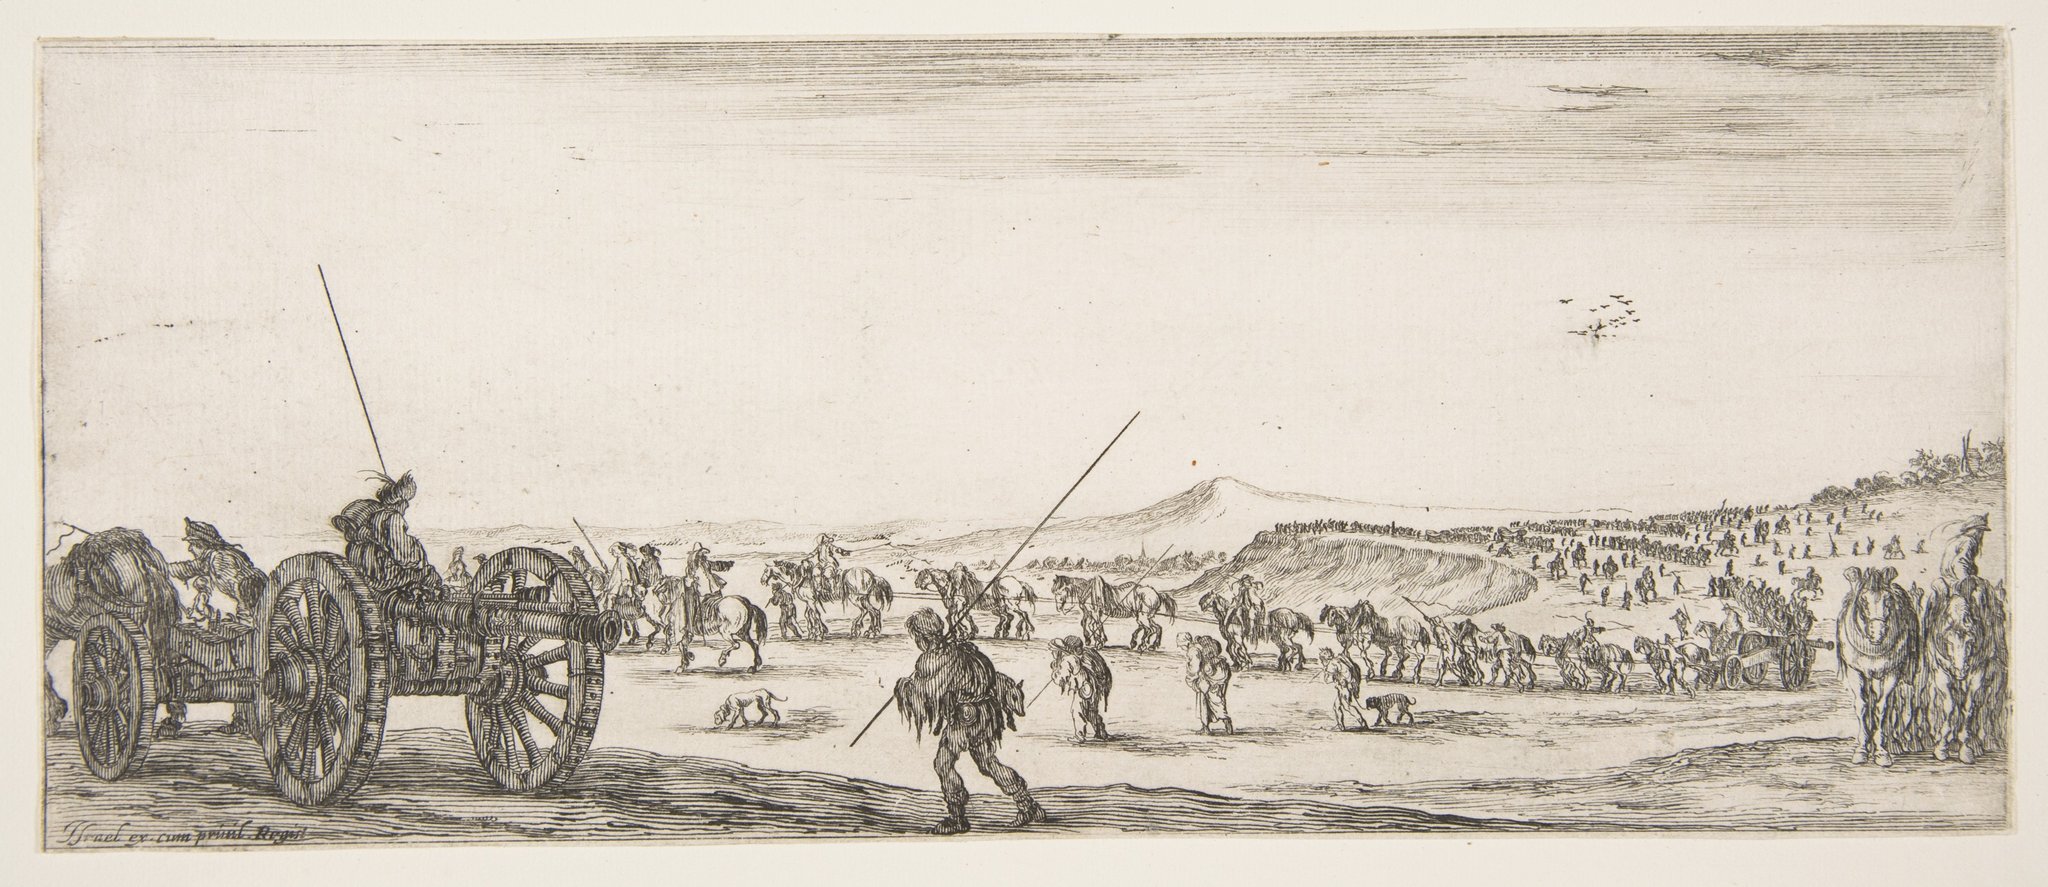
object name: print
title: A procession of horsemen and cannons in the middle ground walking to the left, a cannon and two men to left, from "Peace and War" (Divers desseins tant pour la paix que pour la guerre)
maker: stefano della bella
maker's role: artist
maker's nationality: italian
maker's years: 1610-1664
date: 1641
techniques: etching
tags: cannons,men,dogs,horses,landscapes,carriages